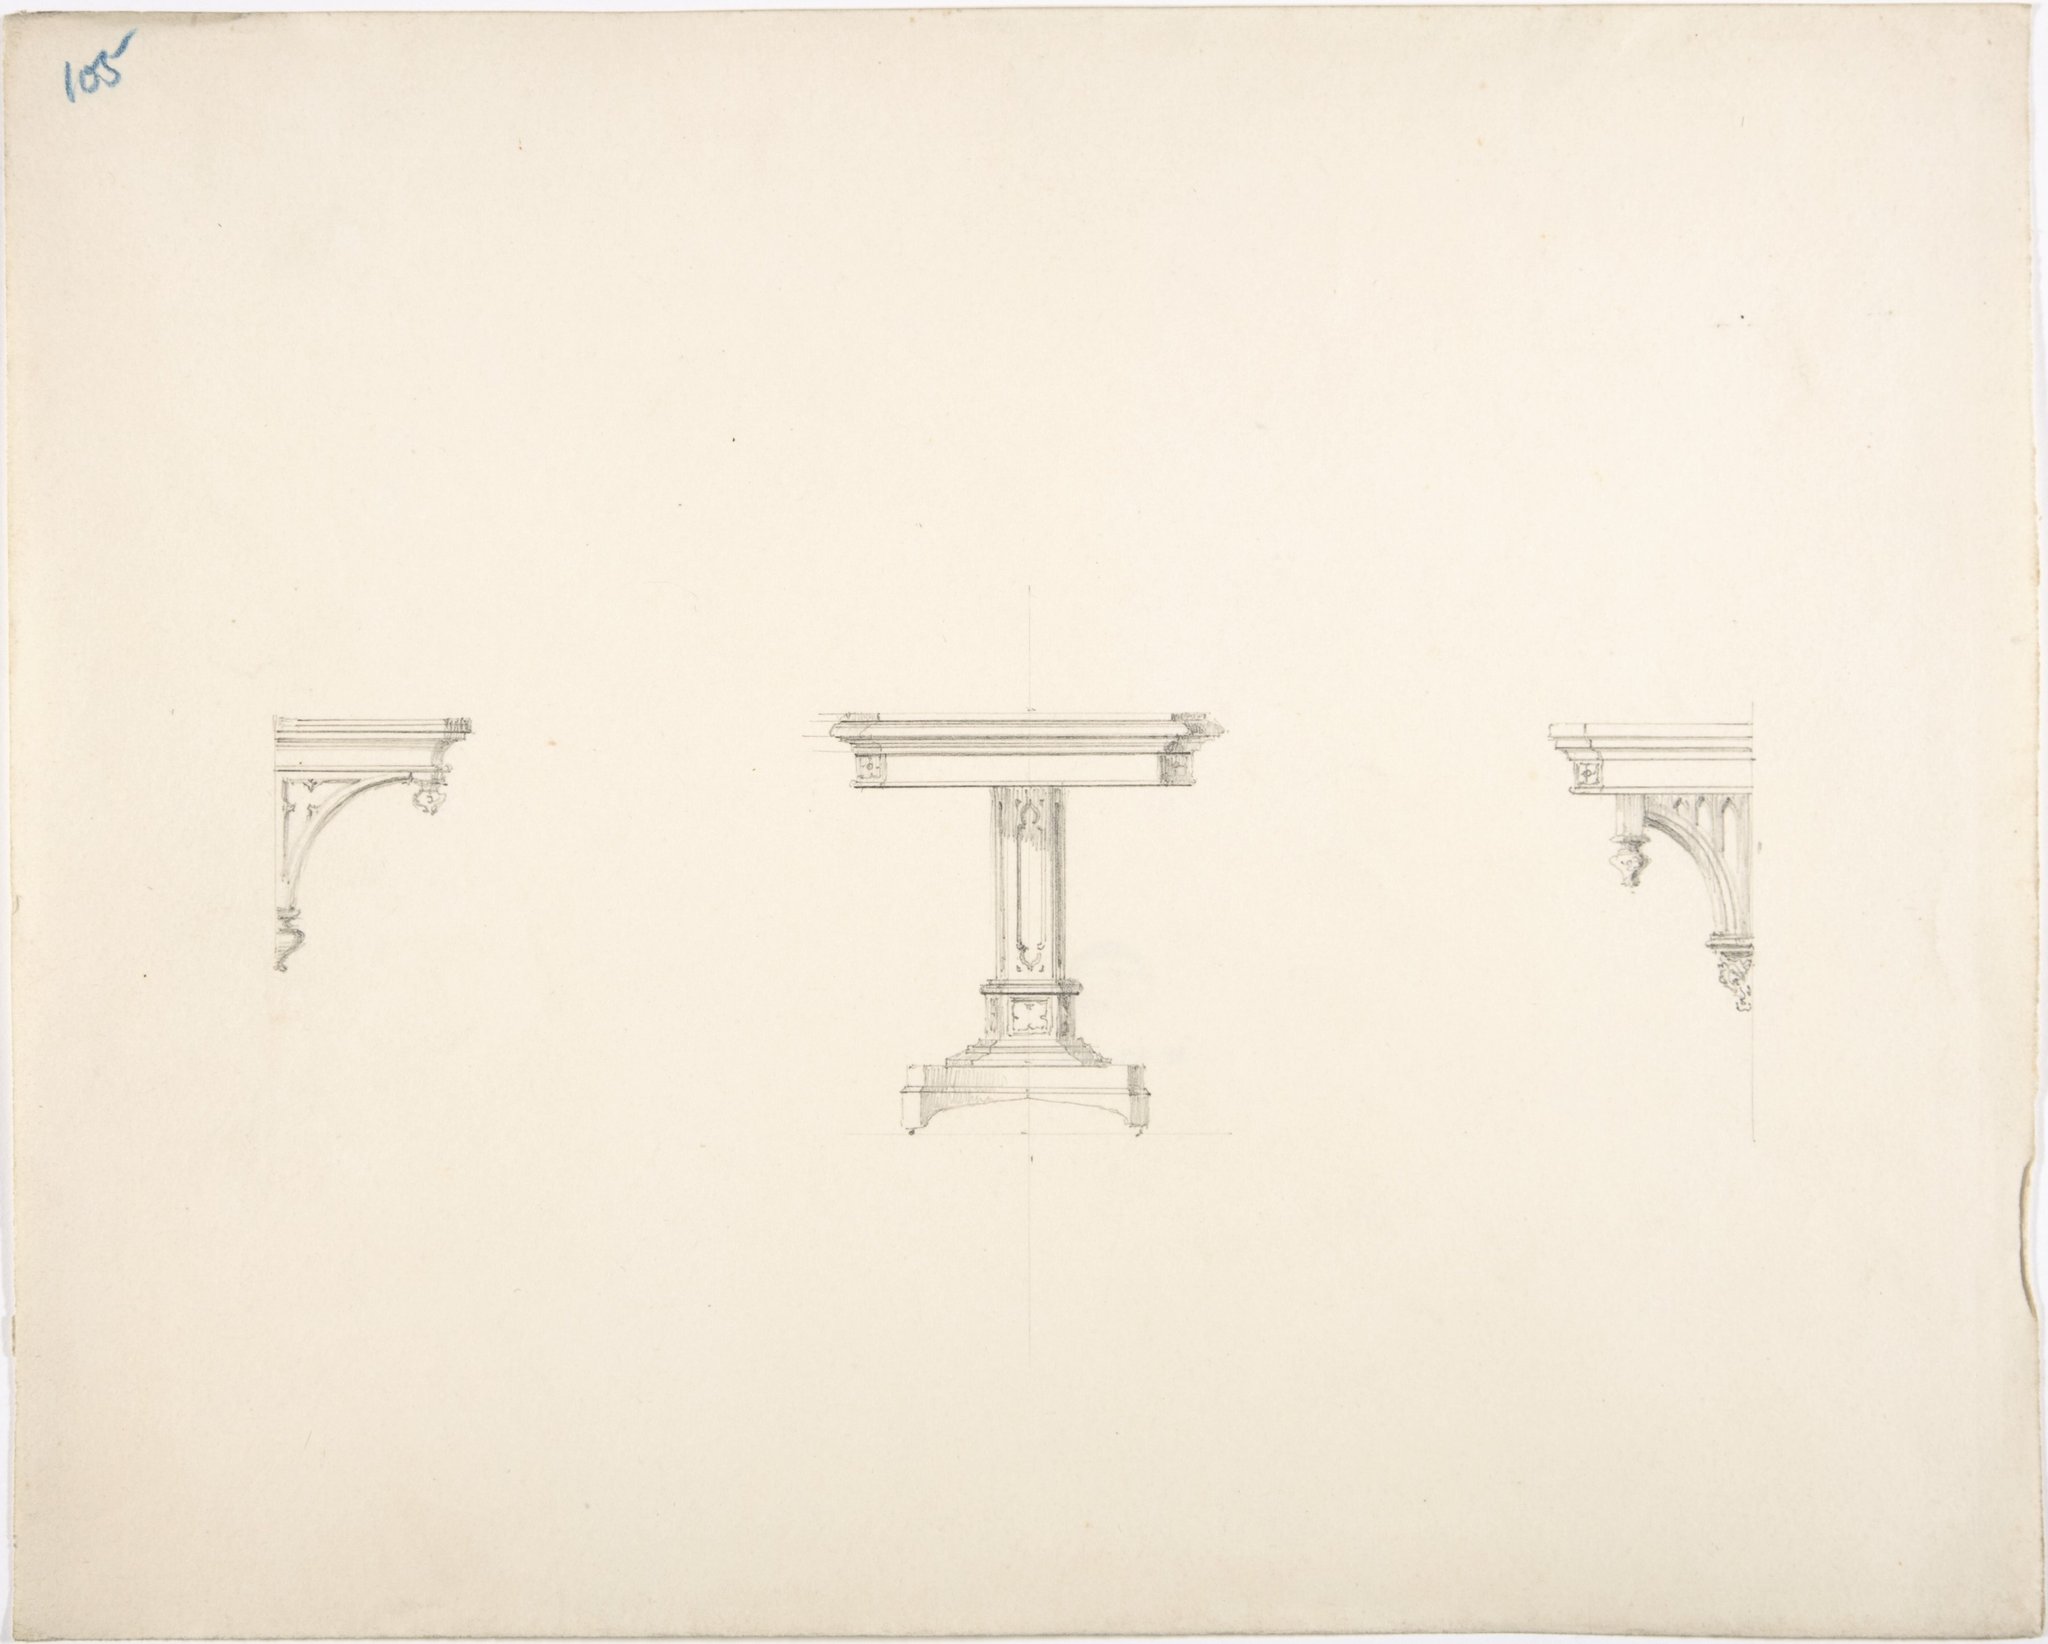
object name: drawing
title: Design for a Small Gothic Pedestal Table and Two Brackets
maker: anonymous, british, 19th century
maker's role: artist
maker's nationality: british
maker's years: 1800-1900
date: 1801-1833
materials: graphite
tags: tables